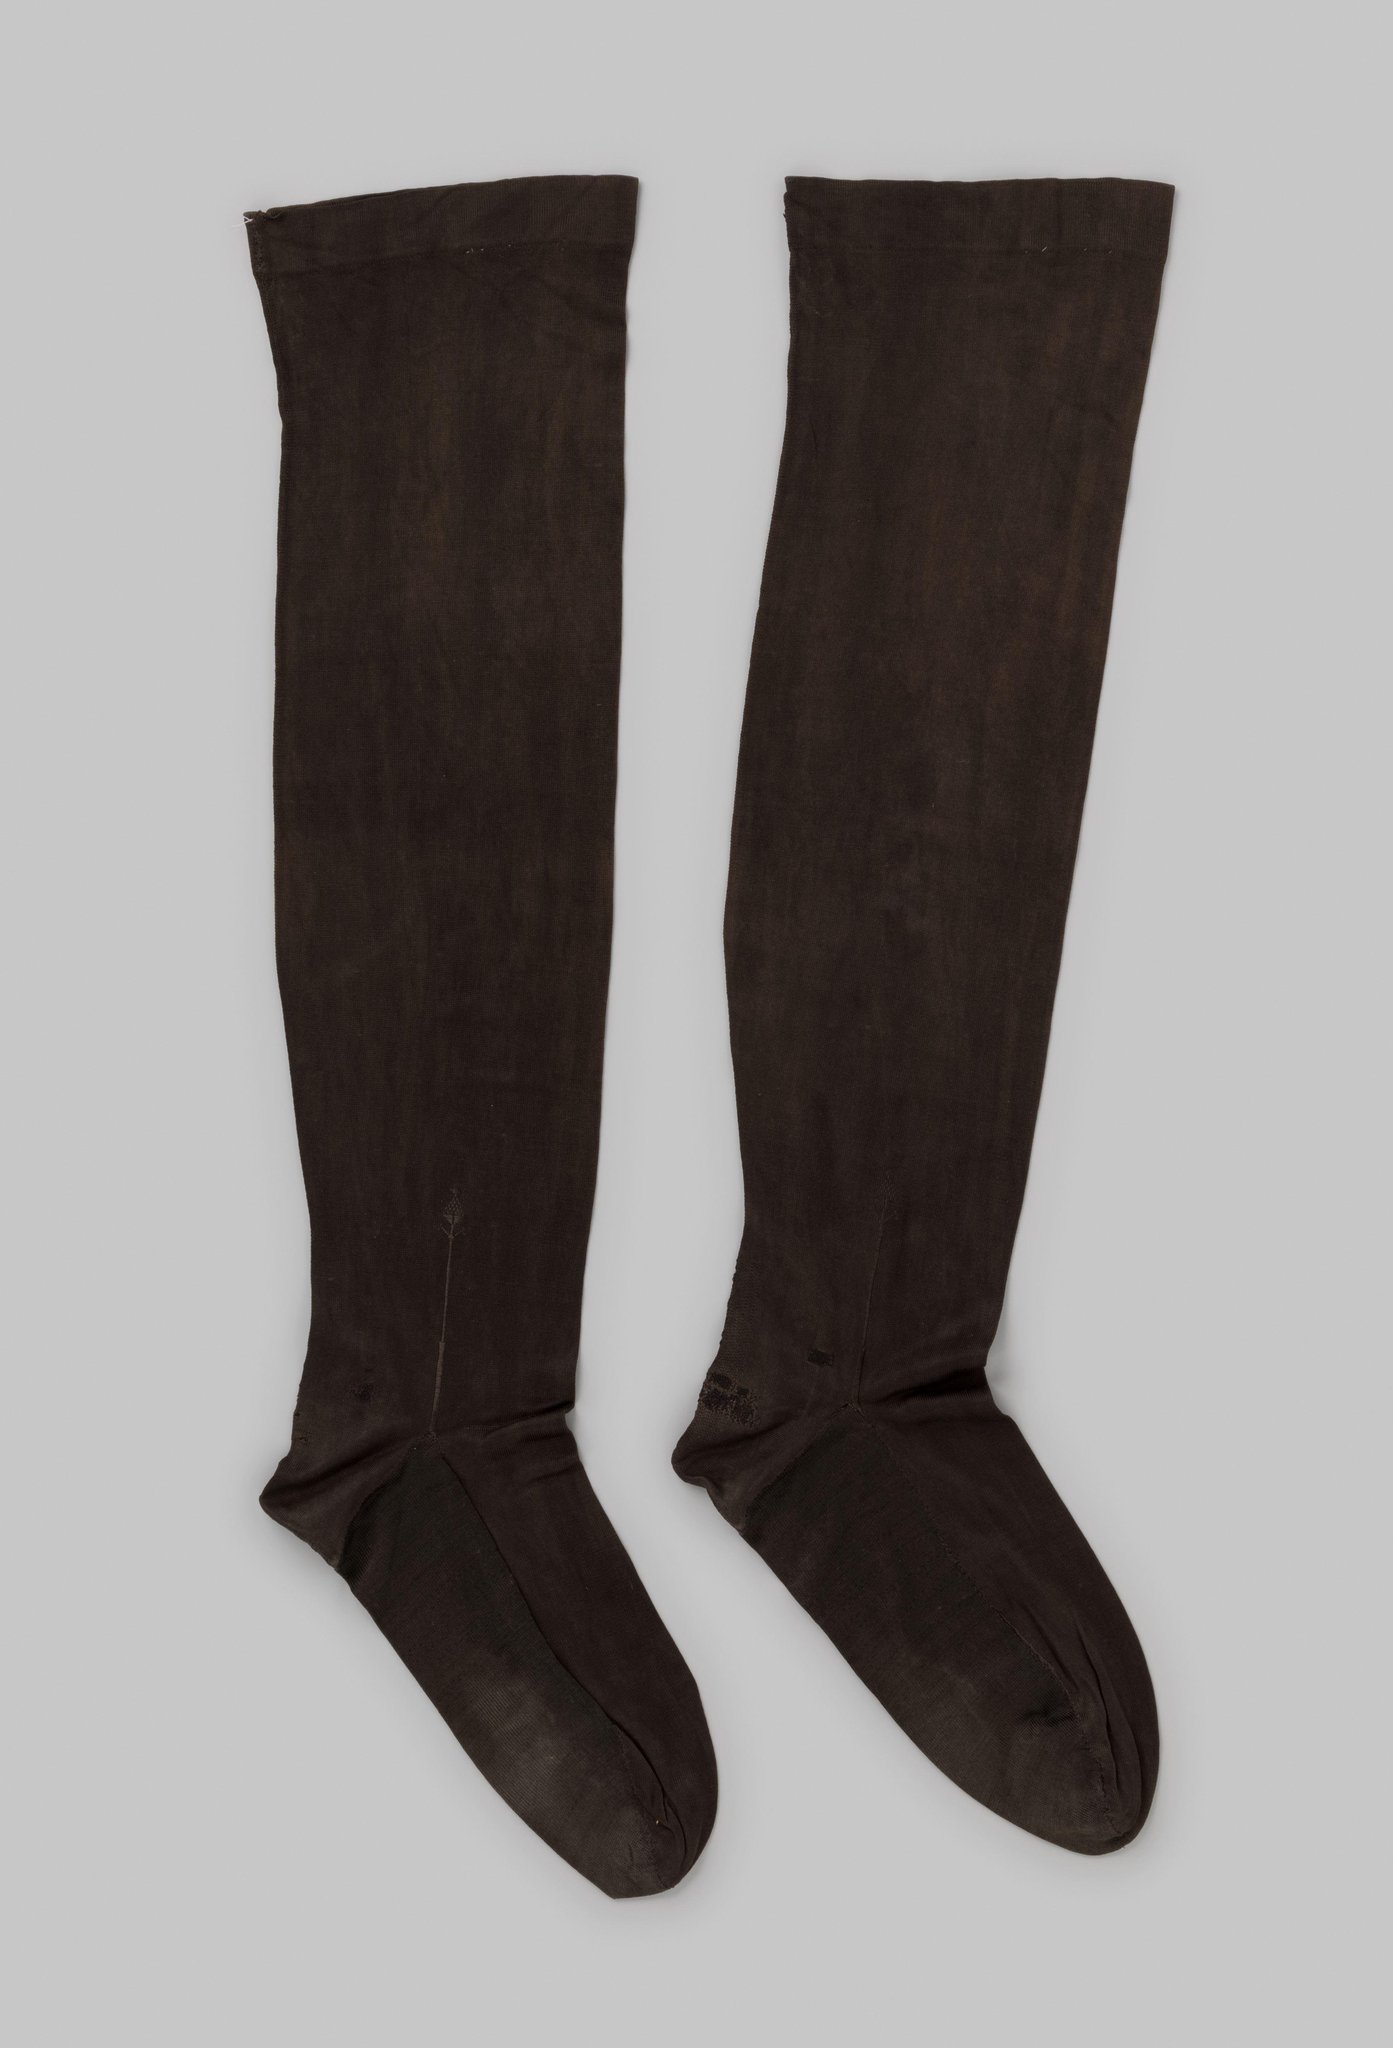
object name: stocking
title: Kous van donkerbruine zijde met pijlvormige versiering op de klink en ingezet katoenen voetstuk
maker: Anonymous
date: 1800-1820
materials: cotton, silk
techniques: embroidered, knitting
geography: france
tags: vught, overveen, minister, staatsman, intendant-generaal van financien, secretaris van staat voor financien, minister van financiën, izaak jean alexandre gogel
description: Kous van donkerbruine zijde met pijlvormige versiering op de klink en ingezet katoenen voetstuk. Naad middenachter.